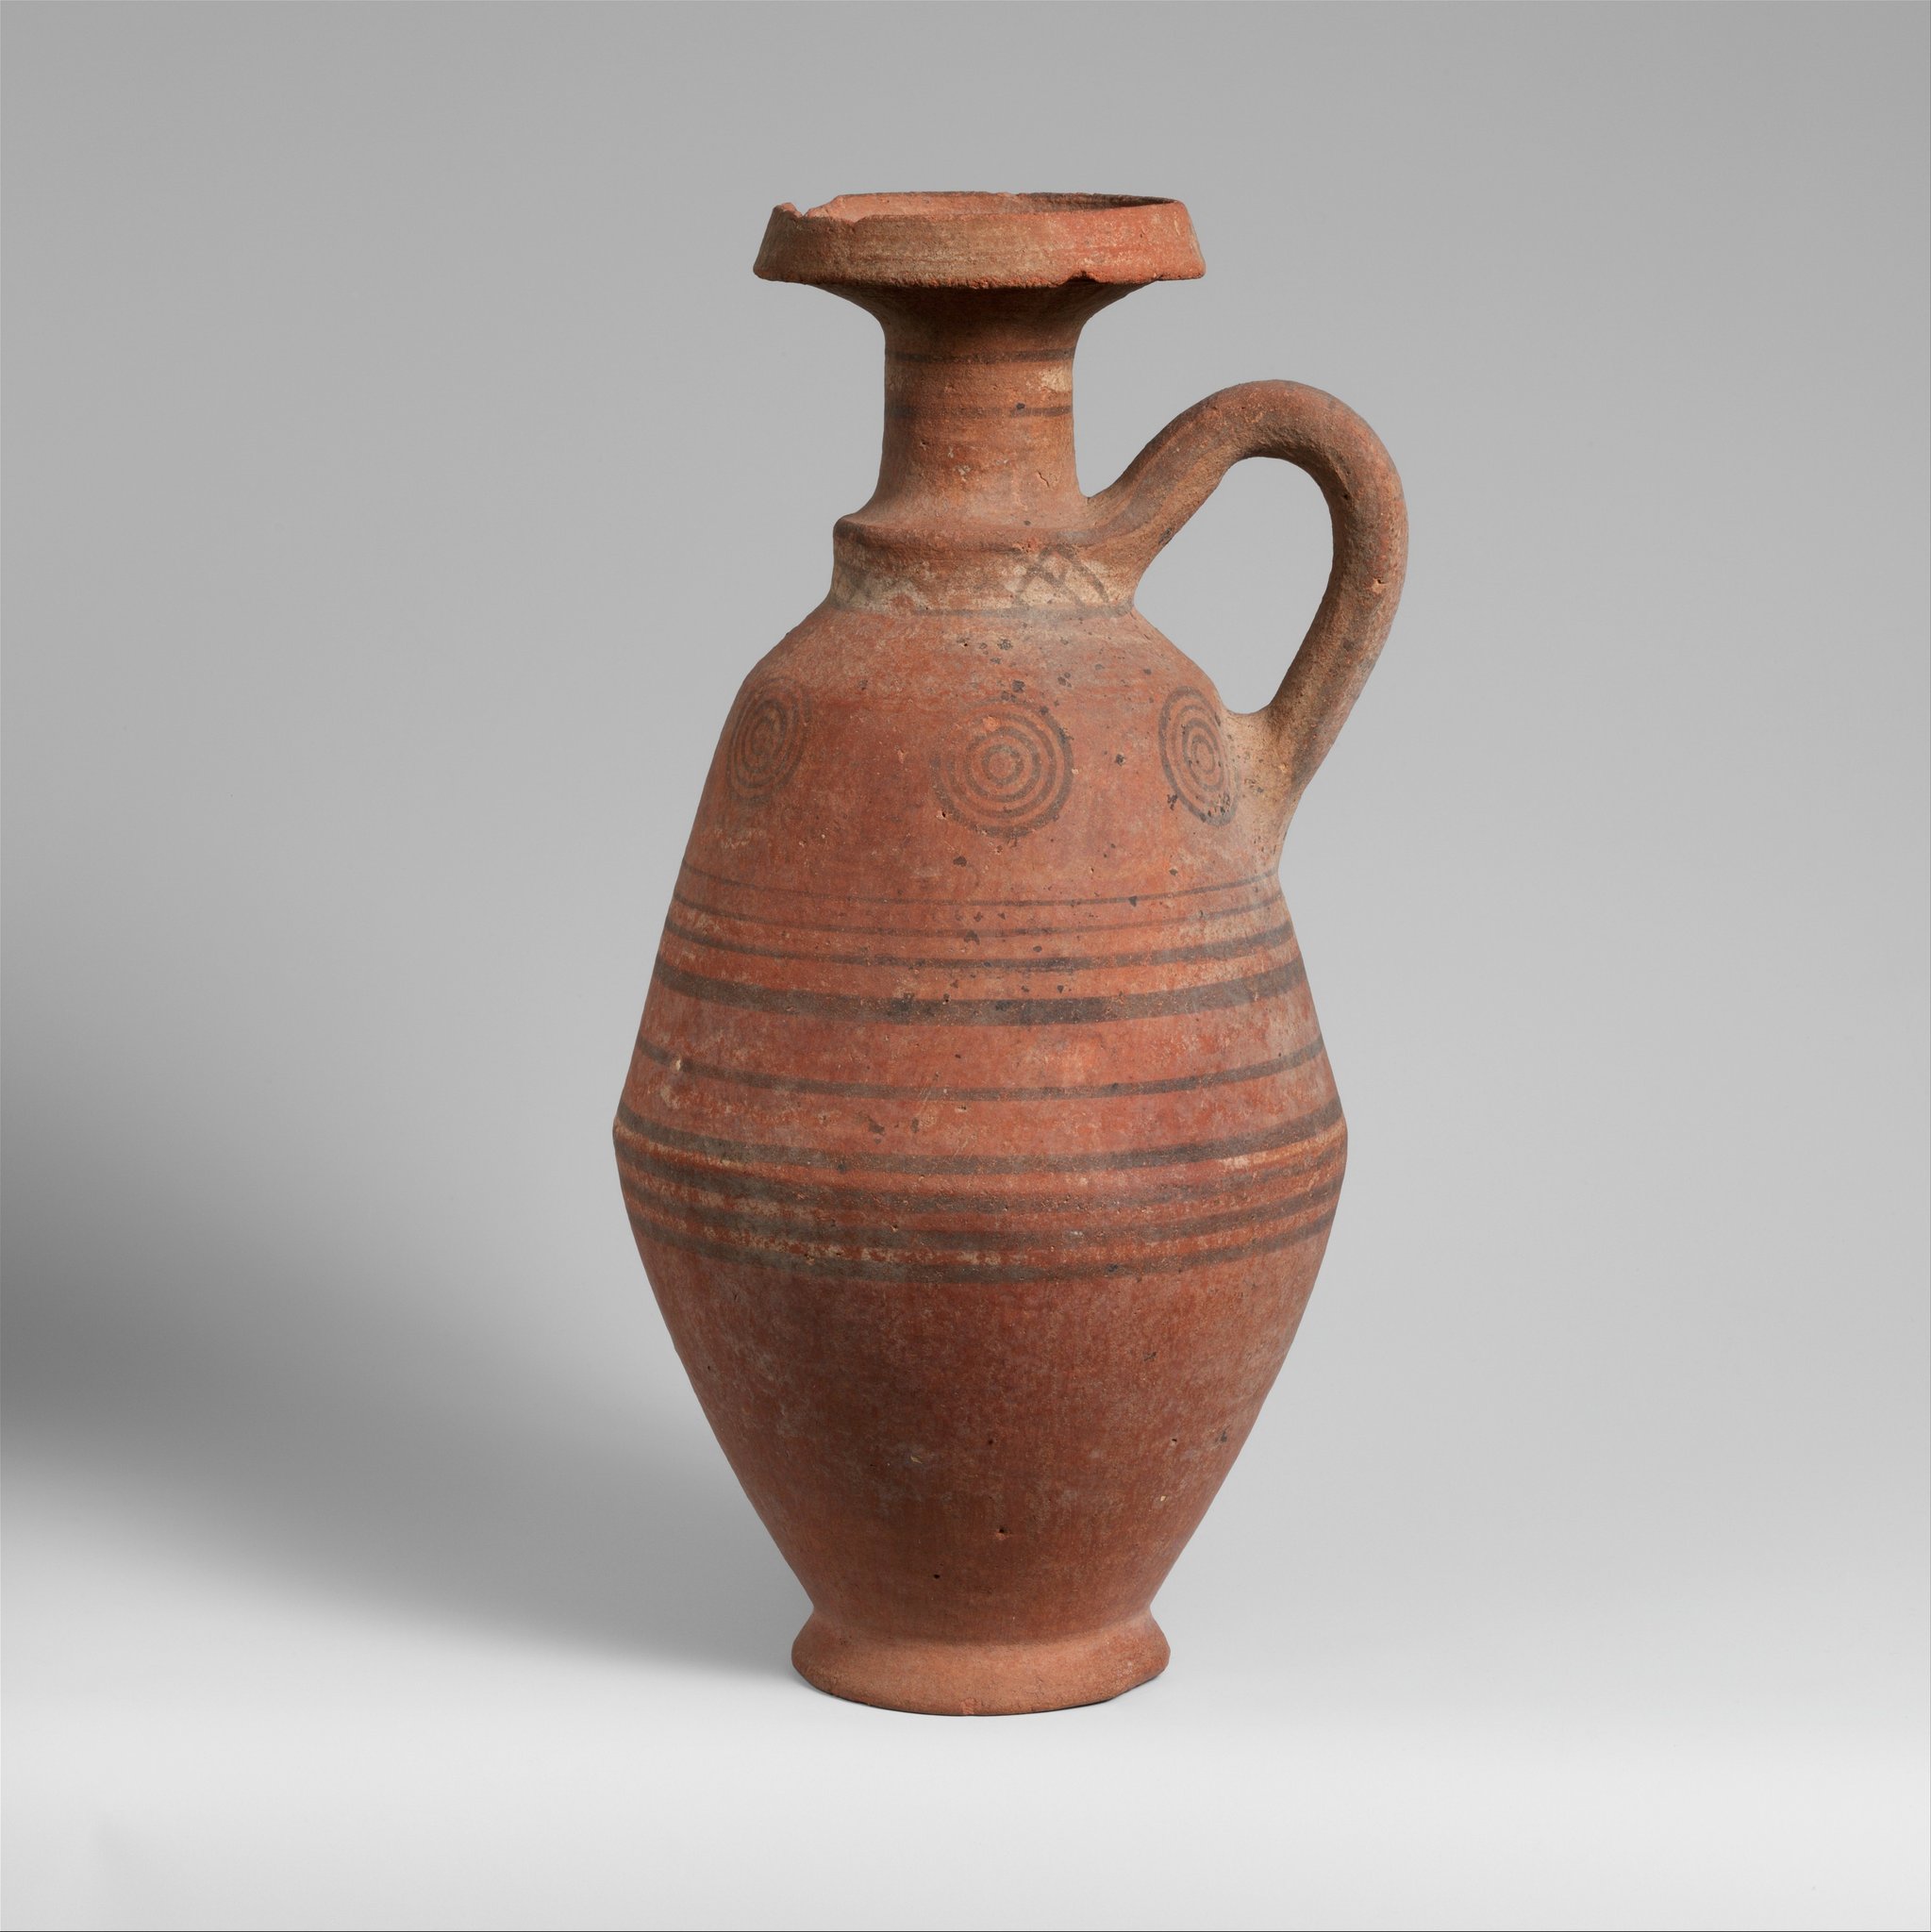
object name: jug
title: Terracotta jug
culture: cypriot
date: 600-480 BCE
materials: terracotta